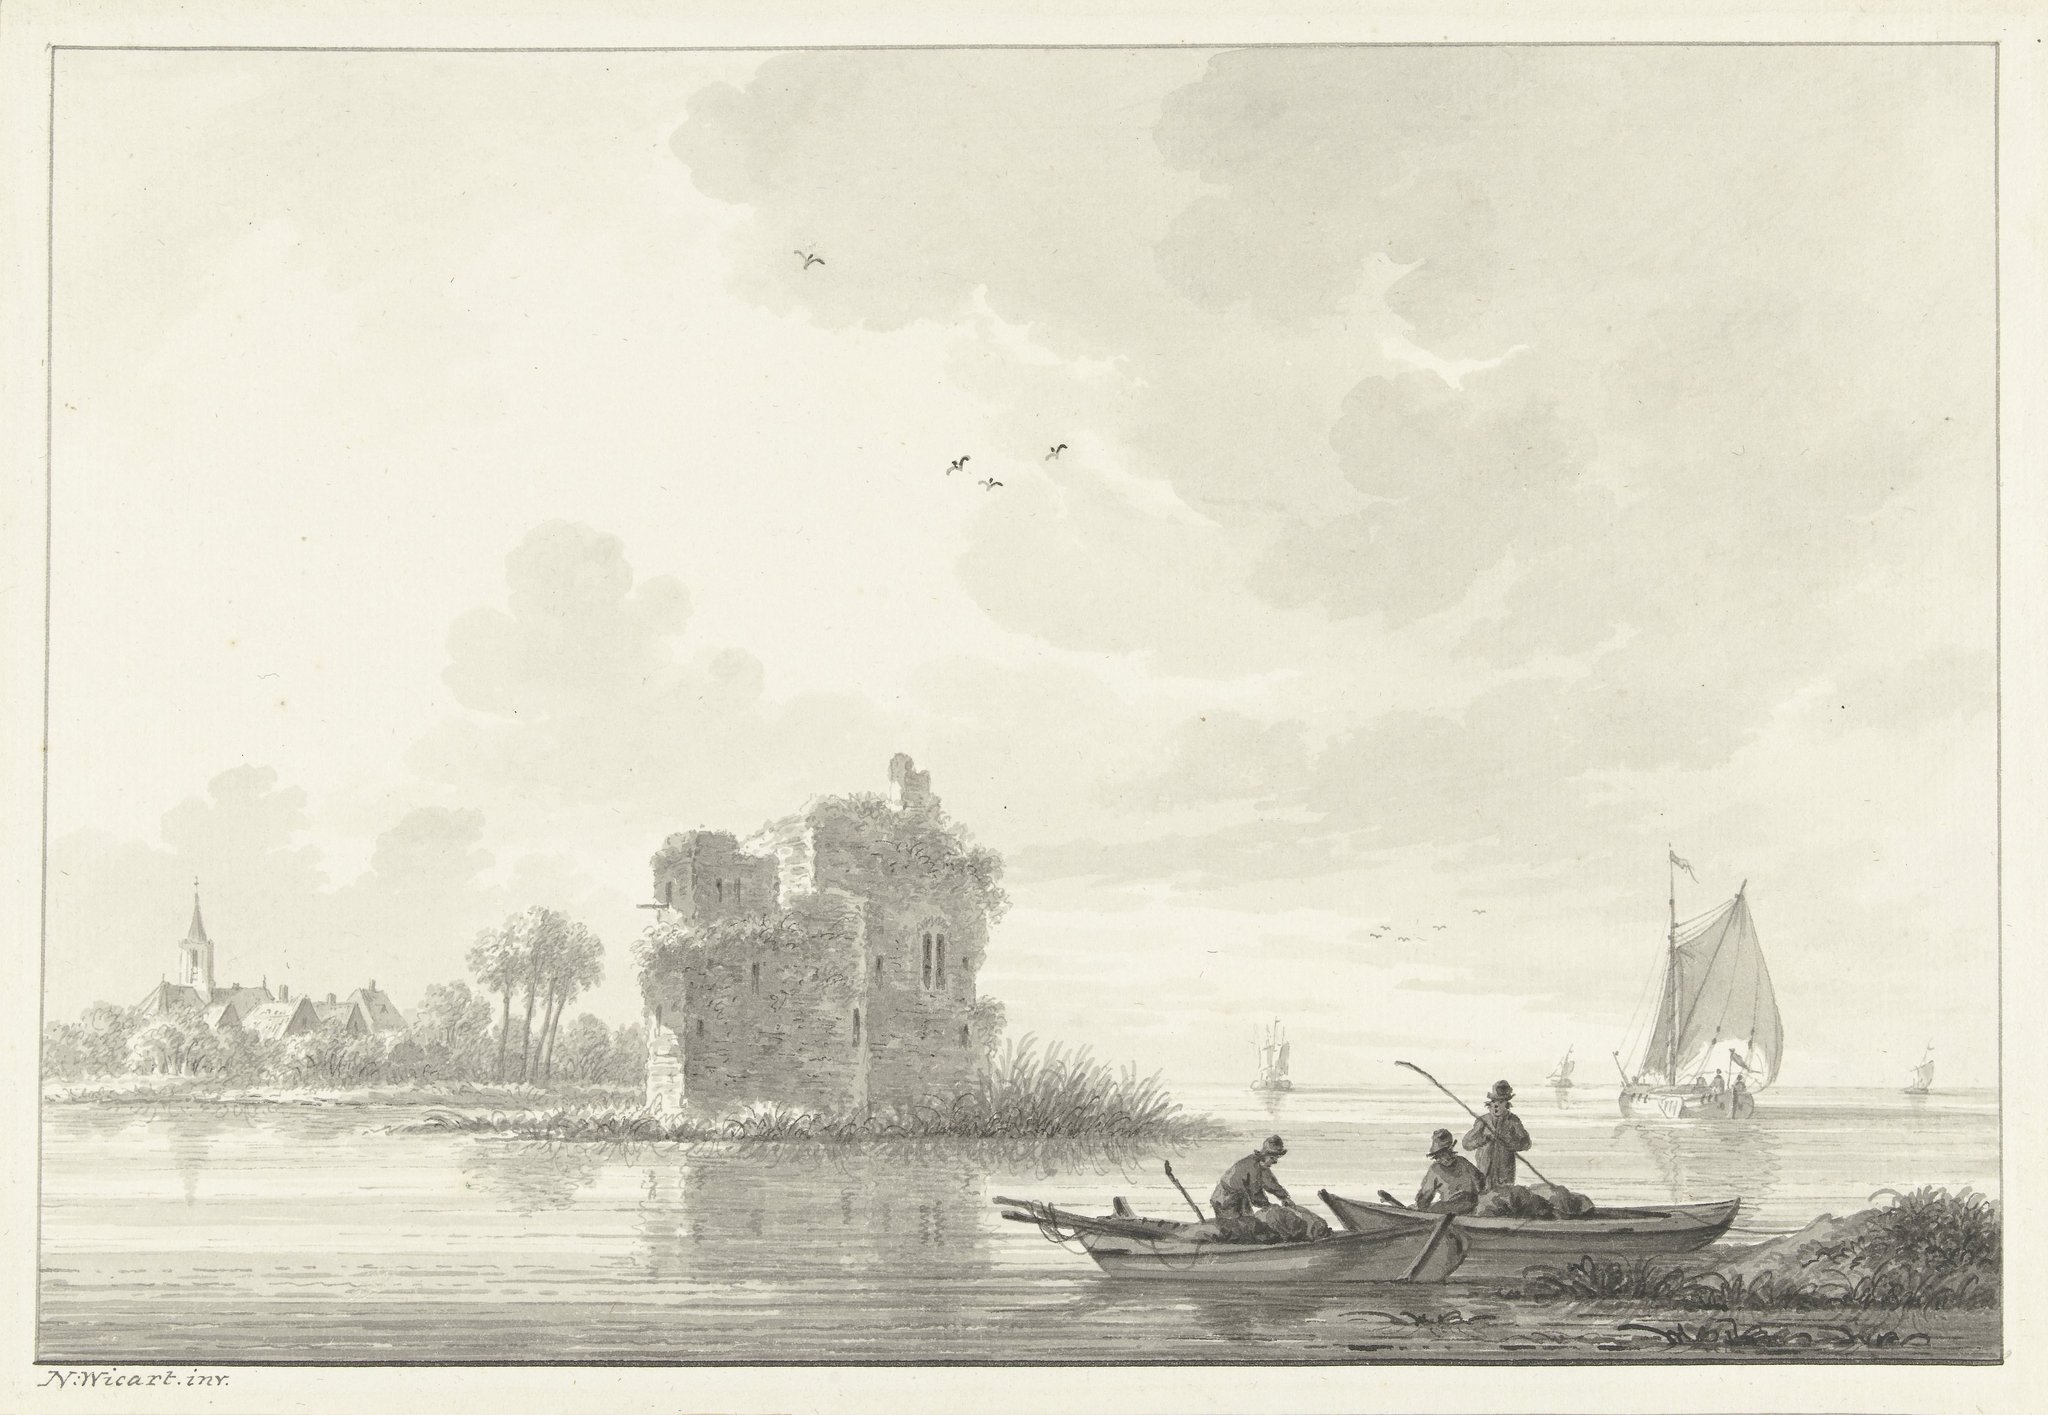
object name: drawing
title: Het dorp Lexmond, met de ruïne van het slot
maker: nicolaas wicart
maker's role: draughtsman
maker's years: 1748-1815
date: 1758-1815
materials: ink, paper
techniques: brush, pen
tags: castle, ruin of a building ~ architecture, village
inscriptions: inscription: ‘'t Dorp Lexmond aan de Lek’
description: Het dorp Lexmond, gezien vanaf de rivier, met de ruïne van het slot.